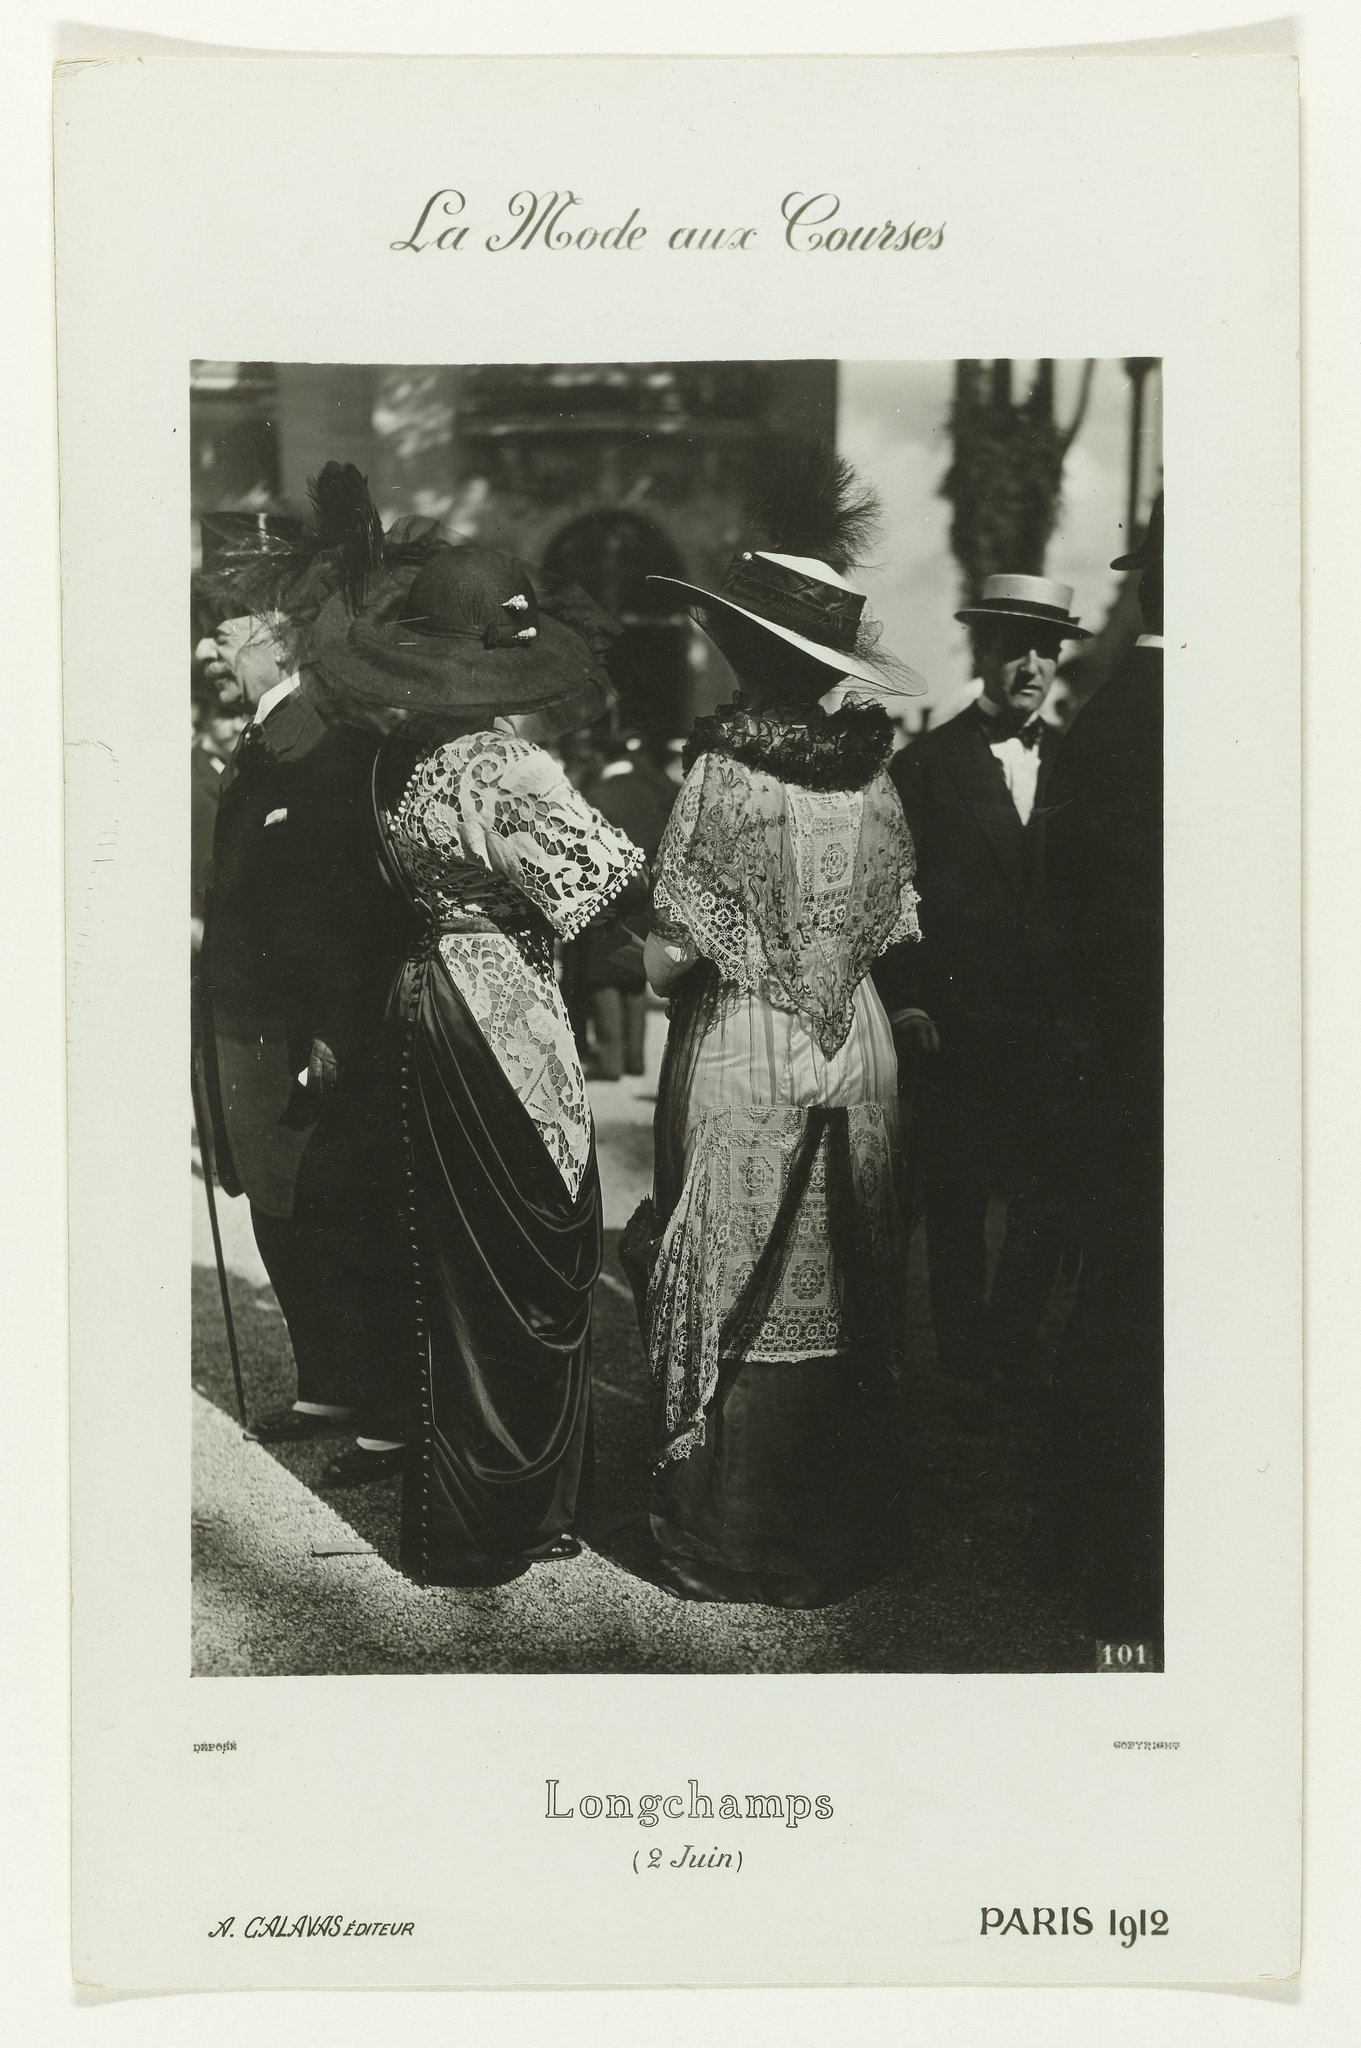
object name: photograph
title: La Mode aux Courses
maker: a. calavas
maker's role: publisher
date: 1912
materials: paper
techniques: gelatin silver print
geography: bois de boulogne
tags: fashionable woman, 'belle'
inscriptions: copyright notice: ‘déposé/ copyright’, number: ‘101’